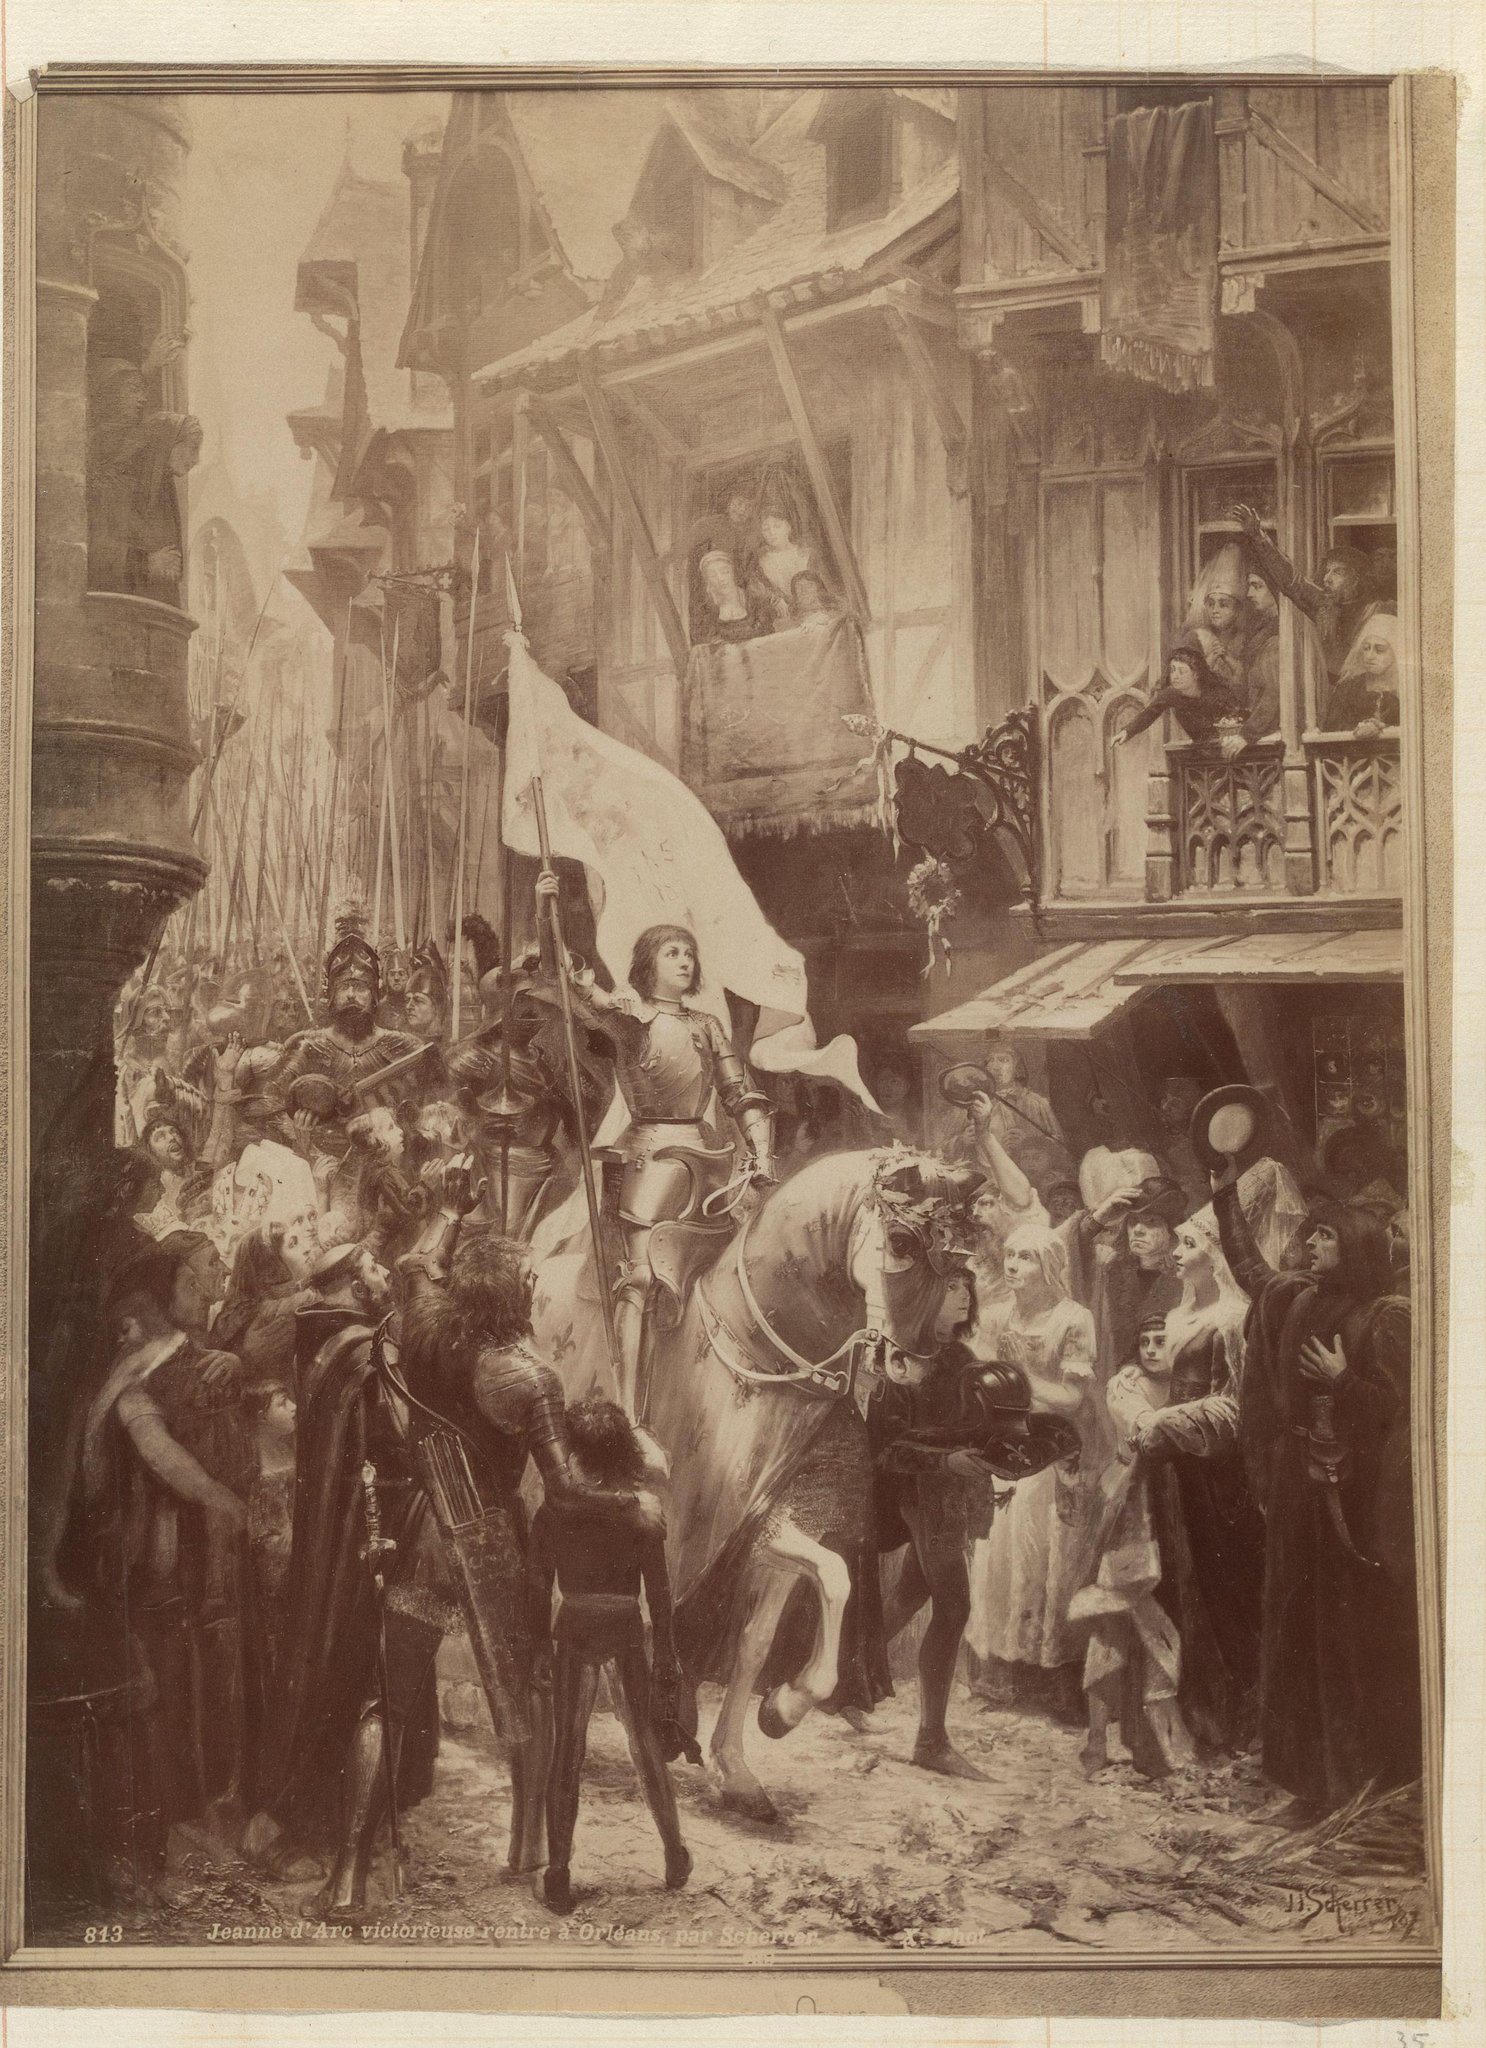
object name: photograph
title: Fotoreproductie van (vermoedelijk) een prent naar een schilderij van Jean-Jacques Scherrer, voorstellend de terugkeer van Jeanne d'Arc in Orléans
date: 1880-1900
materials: paper, photographic support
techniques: albumen print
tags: joan of arc (jeanne d'arc); possible attributes: armour, banner, lance, sword